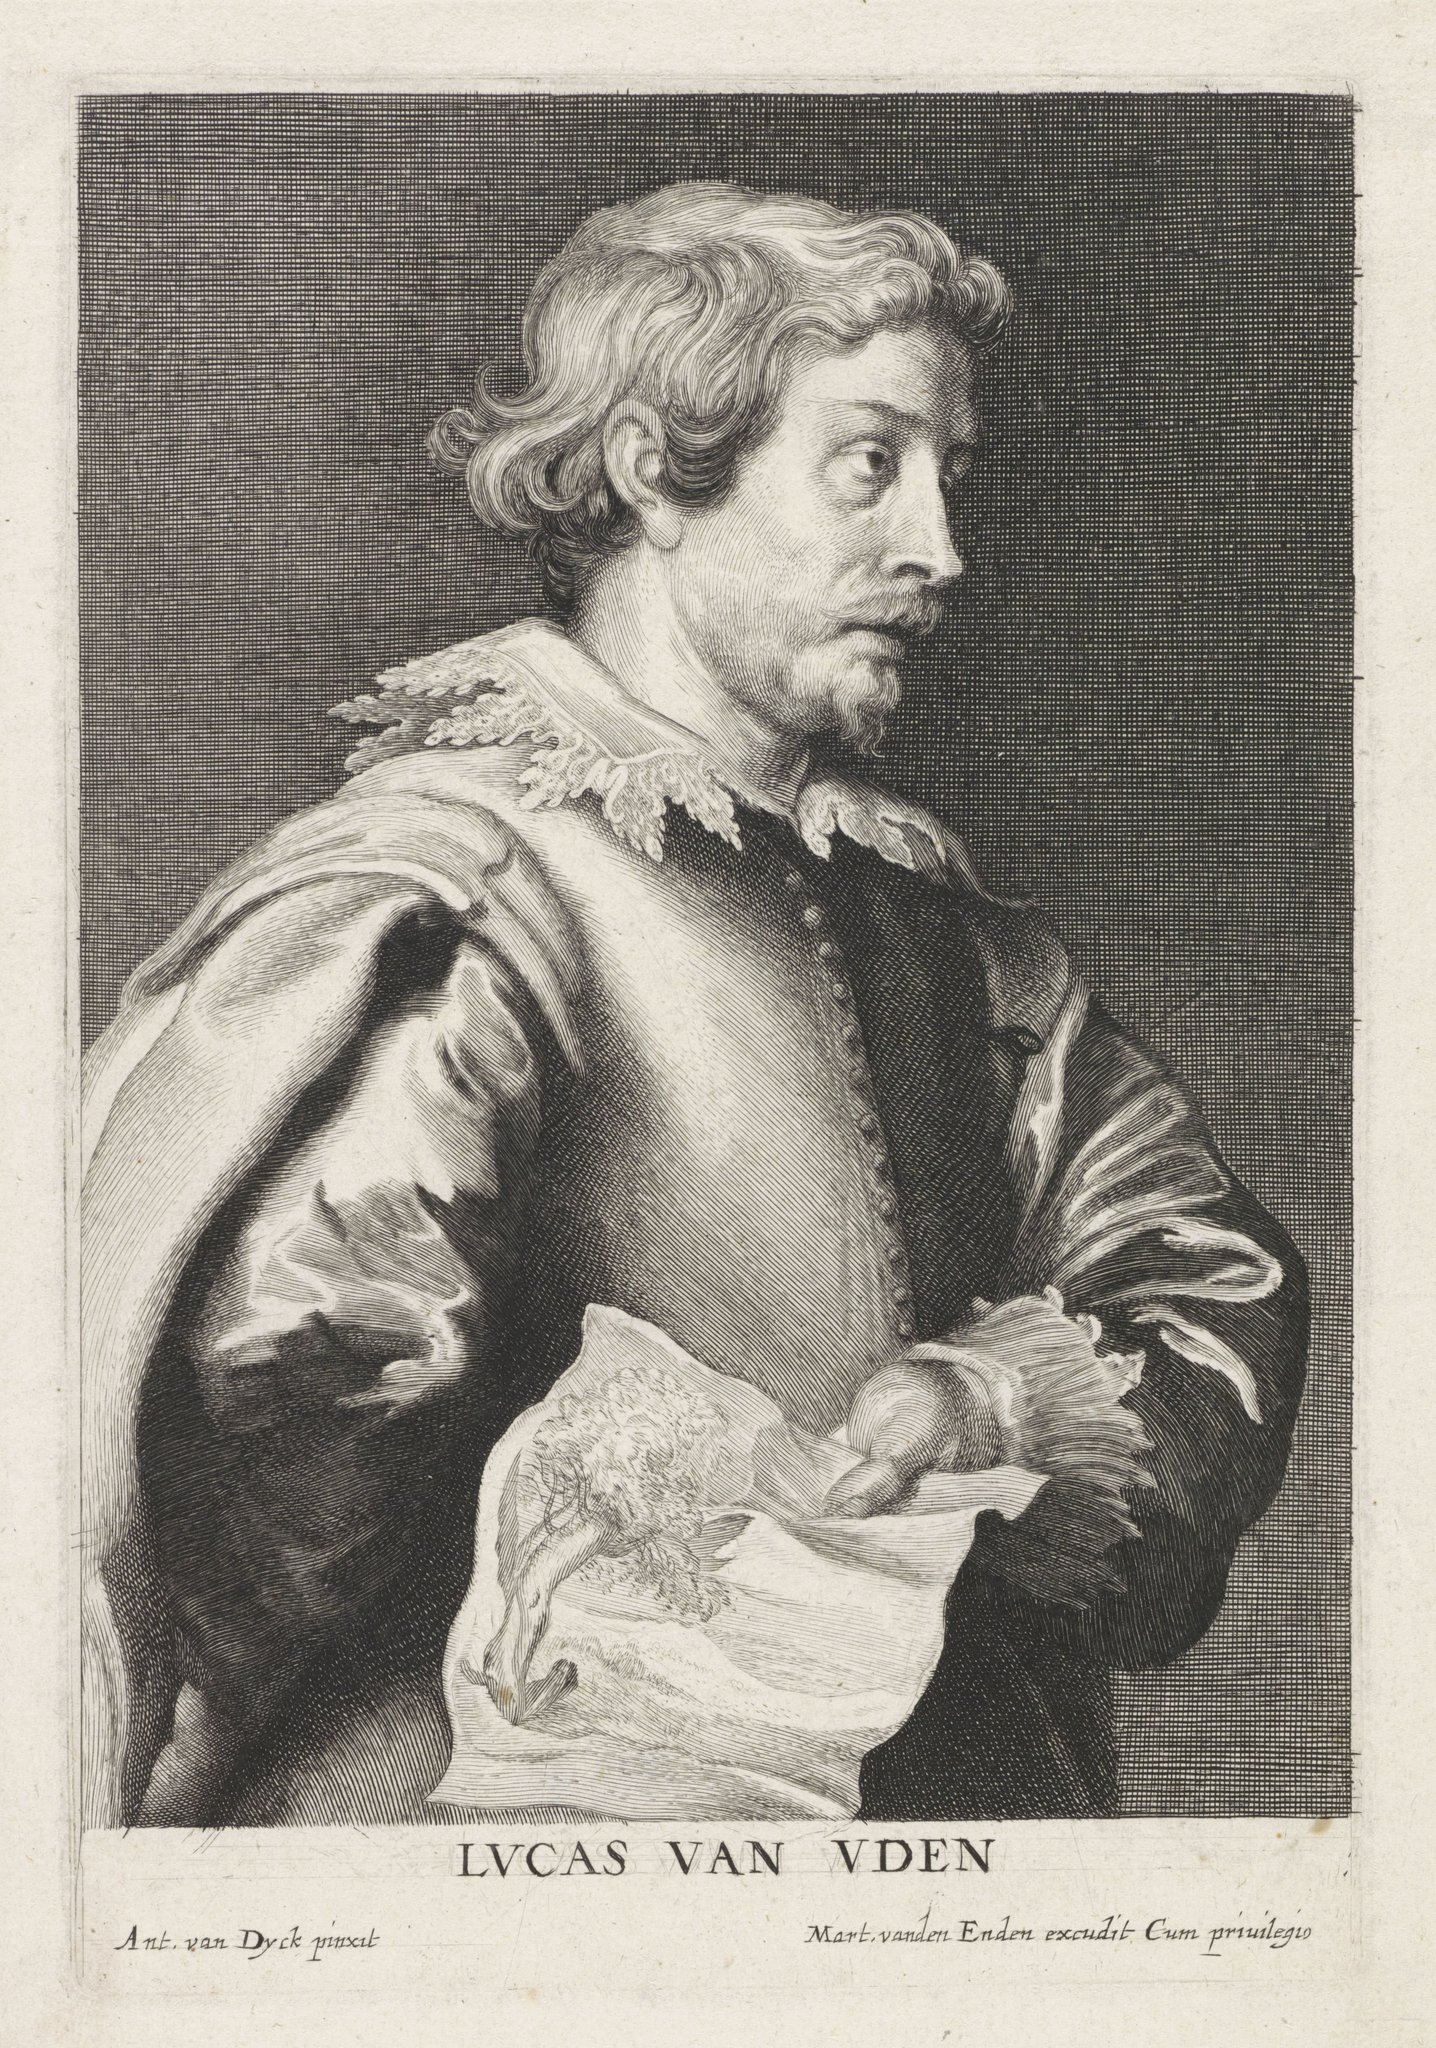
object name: print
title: Iconographie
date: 1630-1646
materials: paper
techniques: engraving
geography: antwerp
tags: draughtsman, lucas van uden, drawing, sketch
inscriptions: collector's mark: Lugt 240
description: Prent gebruikt voor: Icones principum, virorum doctorum, pictorum, chalcographorum, statuariorum nec non amatorum pictoriae artis numero centum ab Ant. van Dyck ad vivum expressae ejusque sumptibus aeri incisae. Antwerpen: Gillis Hendricx, [1645-1646].